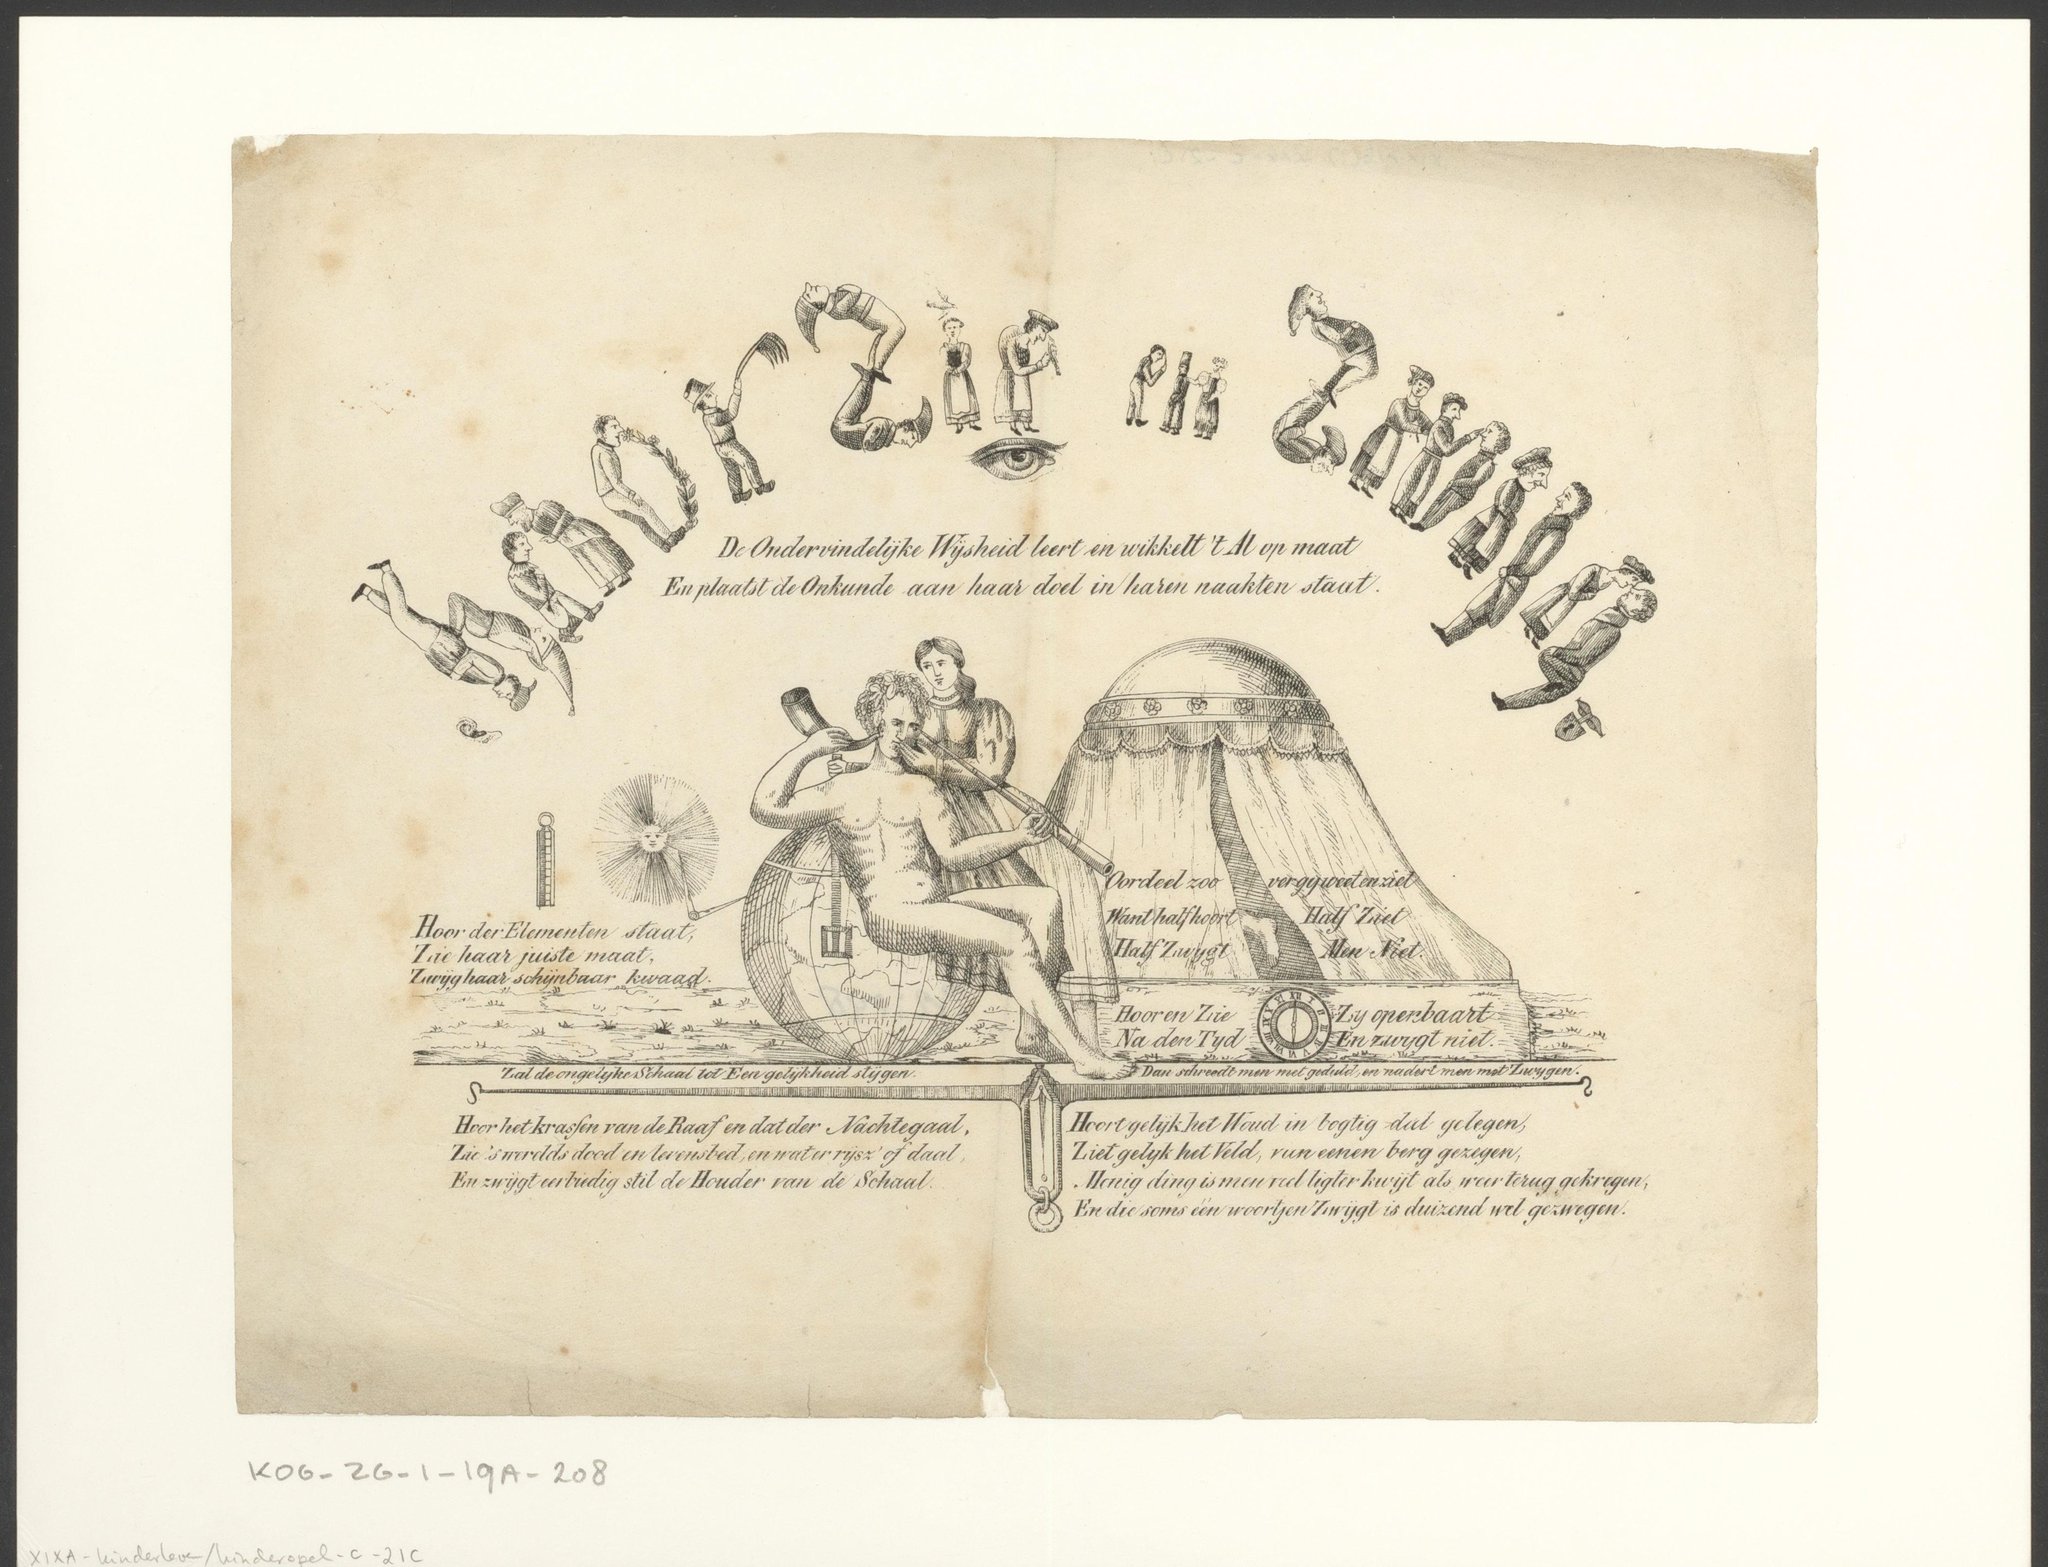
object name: print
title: Horen, zien en zwijgen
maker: Anonymous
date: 1800-1899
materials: paper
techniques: lithograph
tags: hearing-aid, sight, looking (one of the five senses)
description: Bovenaan vormen figuren de tekst: Hoor Zie en Zwijg. Hier onder een naakte zittende man op een globe. Hij houdt een hoorn bij zijn oor en een telescoop aan zijn oog. Een geklede vrouw zit achter hem en houdt een hand voor zijn mond. Onderaan een vers in zeven regels. Onderwerpsrubrieken binnen de Atlas Zeden en Gewoonten: Zeden en Gewoonten in Engeren Zin, Des menschen beging, midden en einde, Kinderleven – Kinderspel en Kinderprenten.